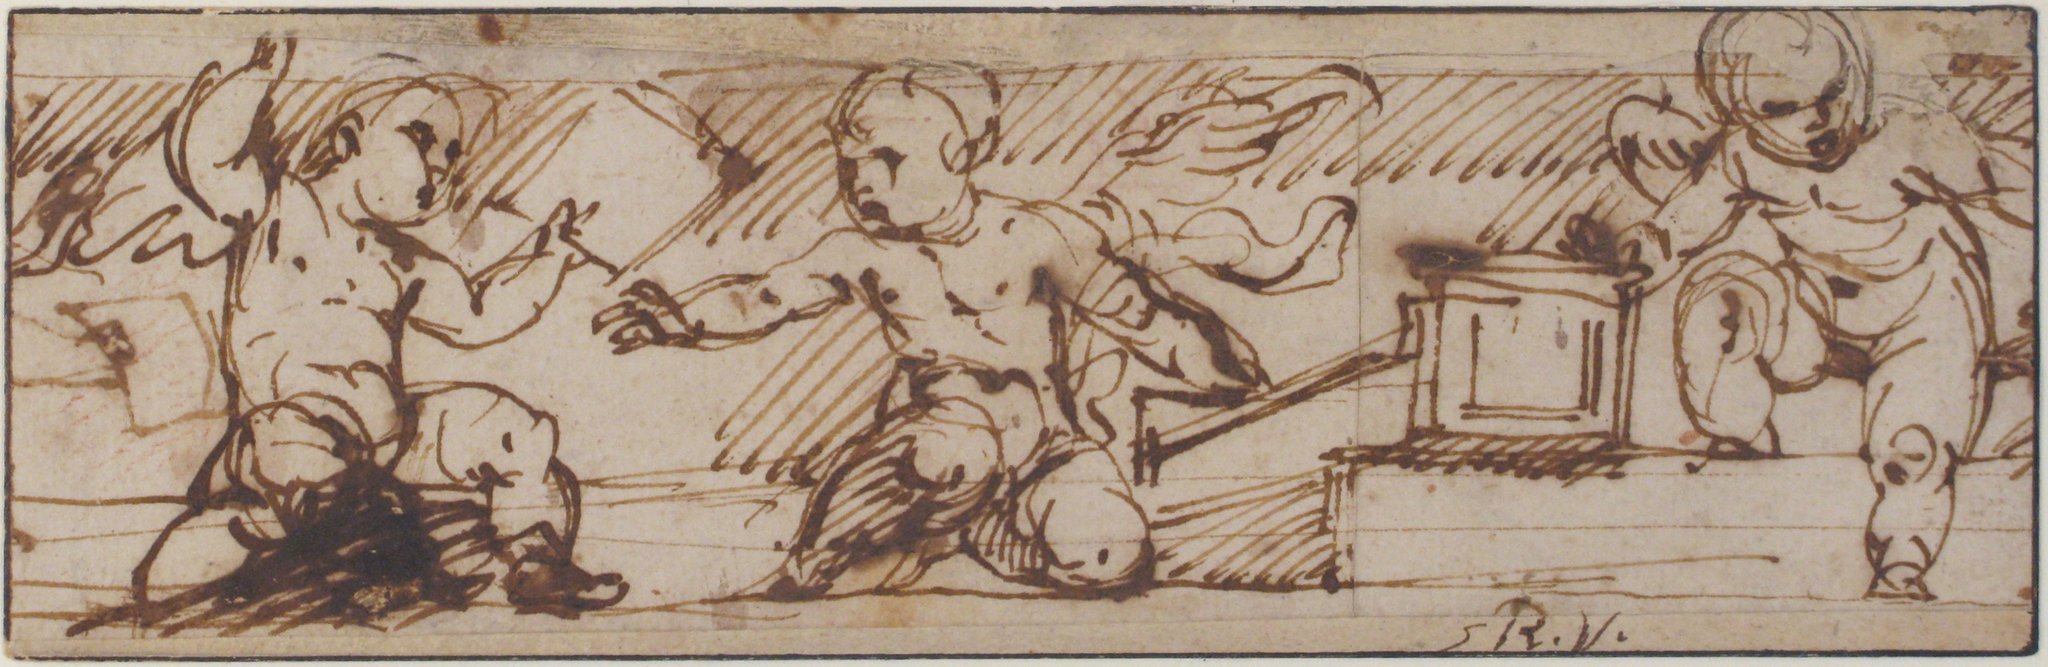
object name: drawing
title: Putti with a Small Keyboard Instrument and Music Books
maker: daniele crespi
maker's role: artist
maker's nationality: italian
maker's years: 1597-1630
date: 1597-1630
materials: ink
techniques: pen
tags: musical instruments,books